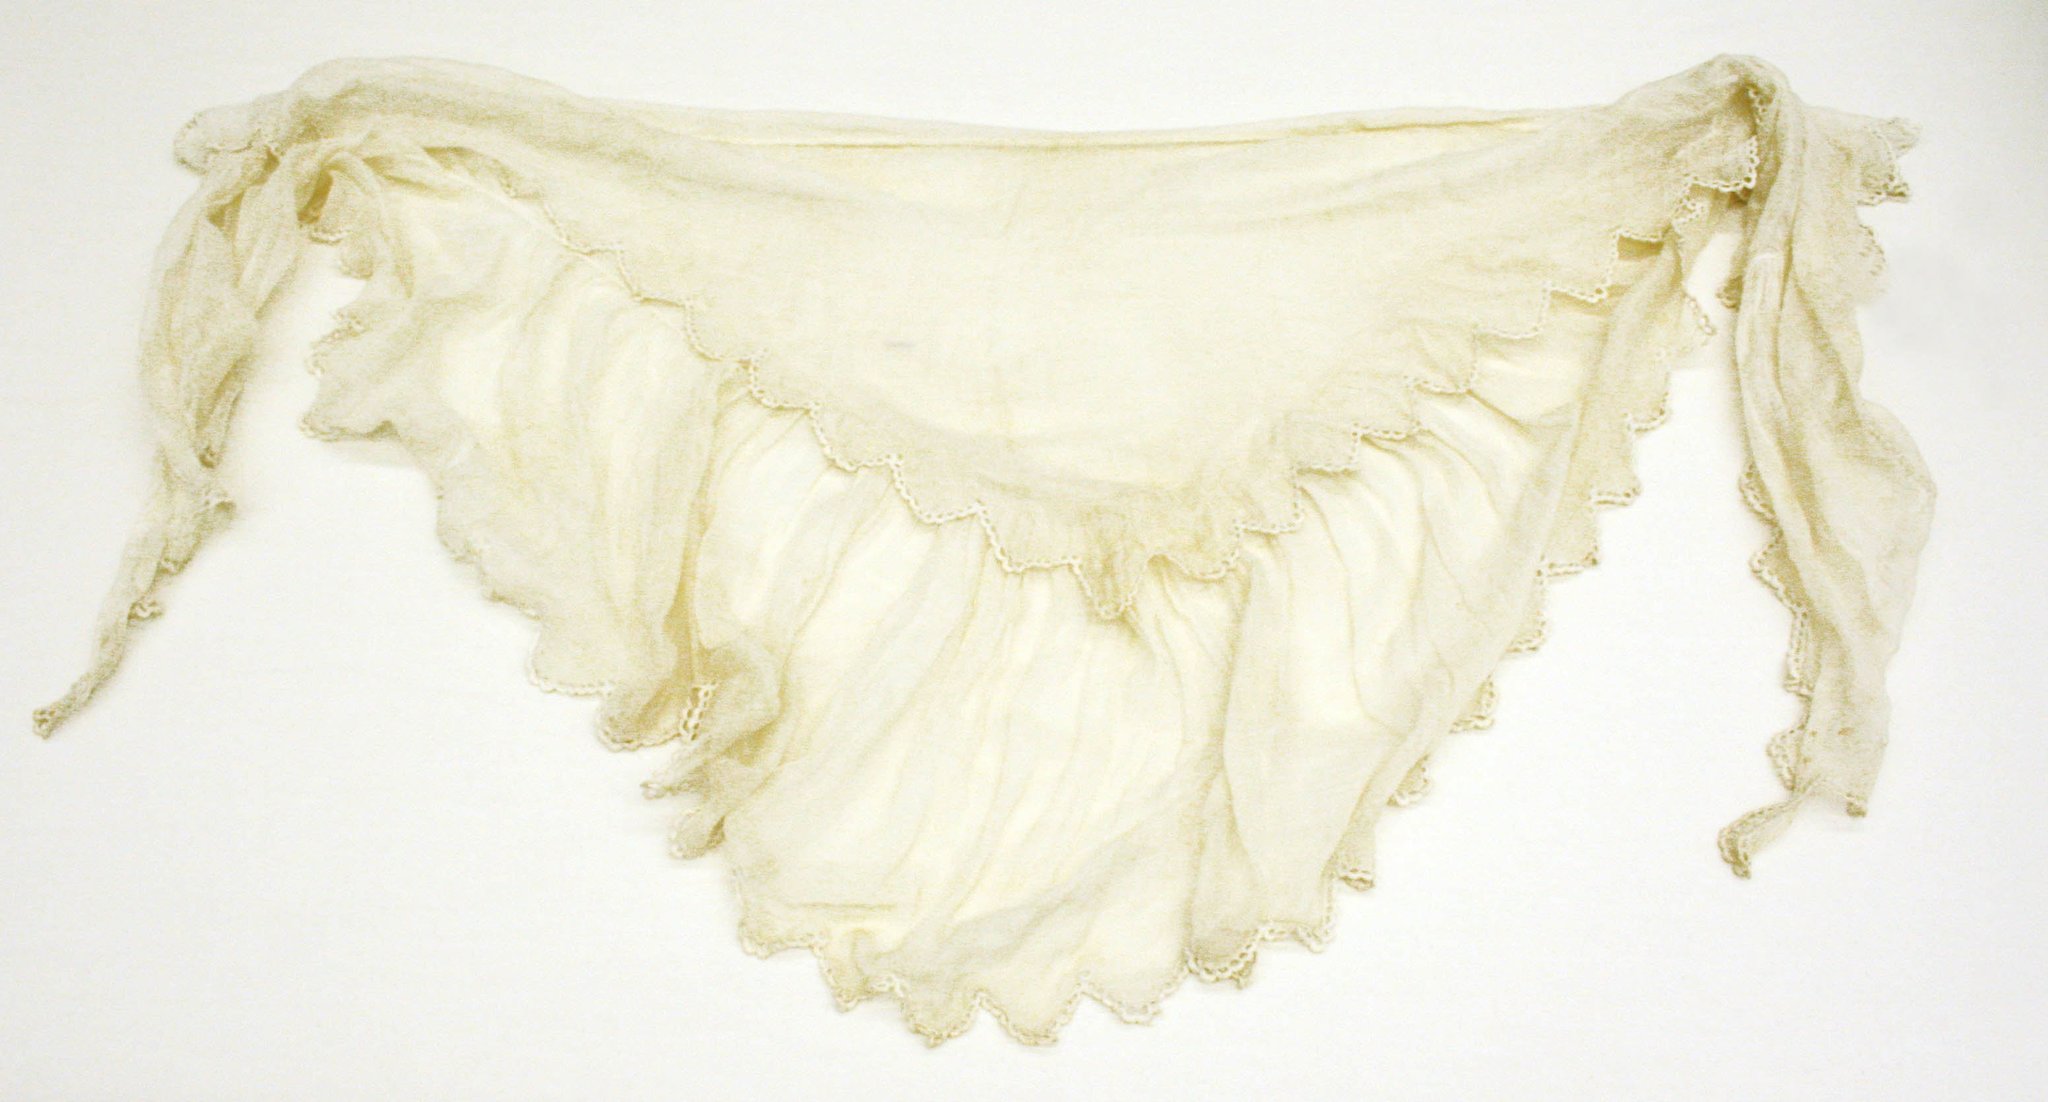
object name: fichu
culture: american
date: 1801-1833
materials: cotton